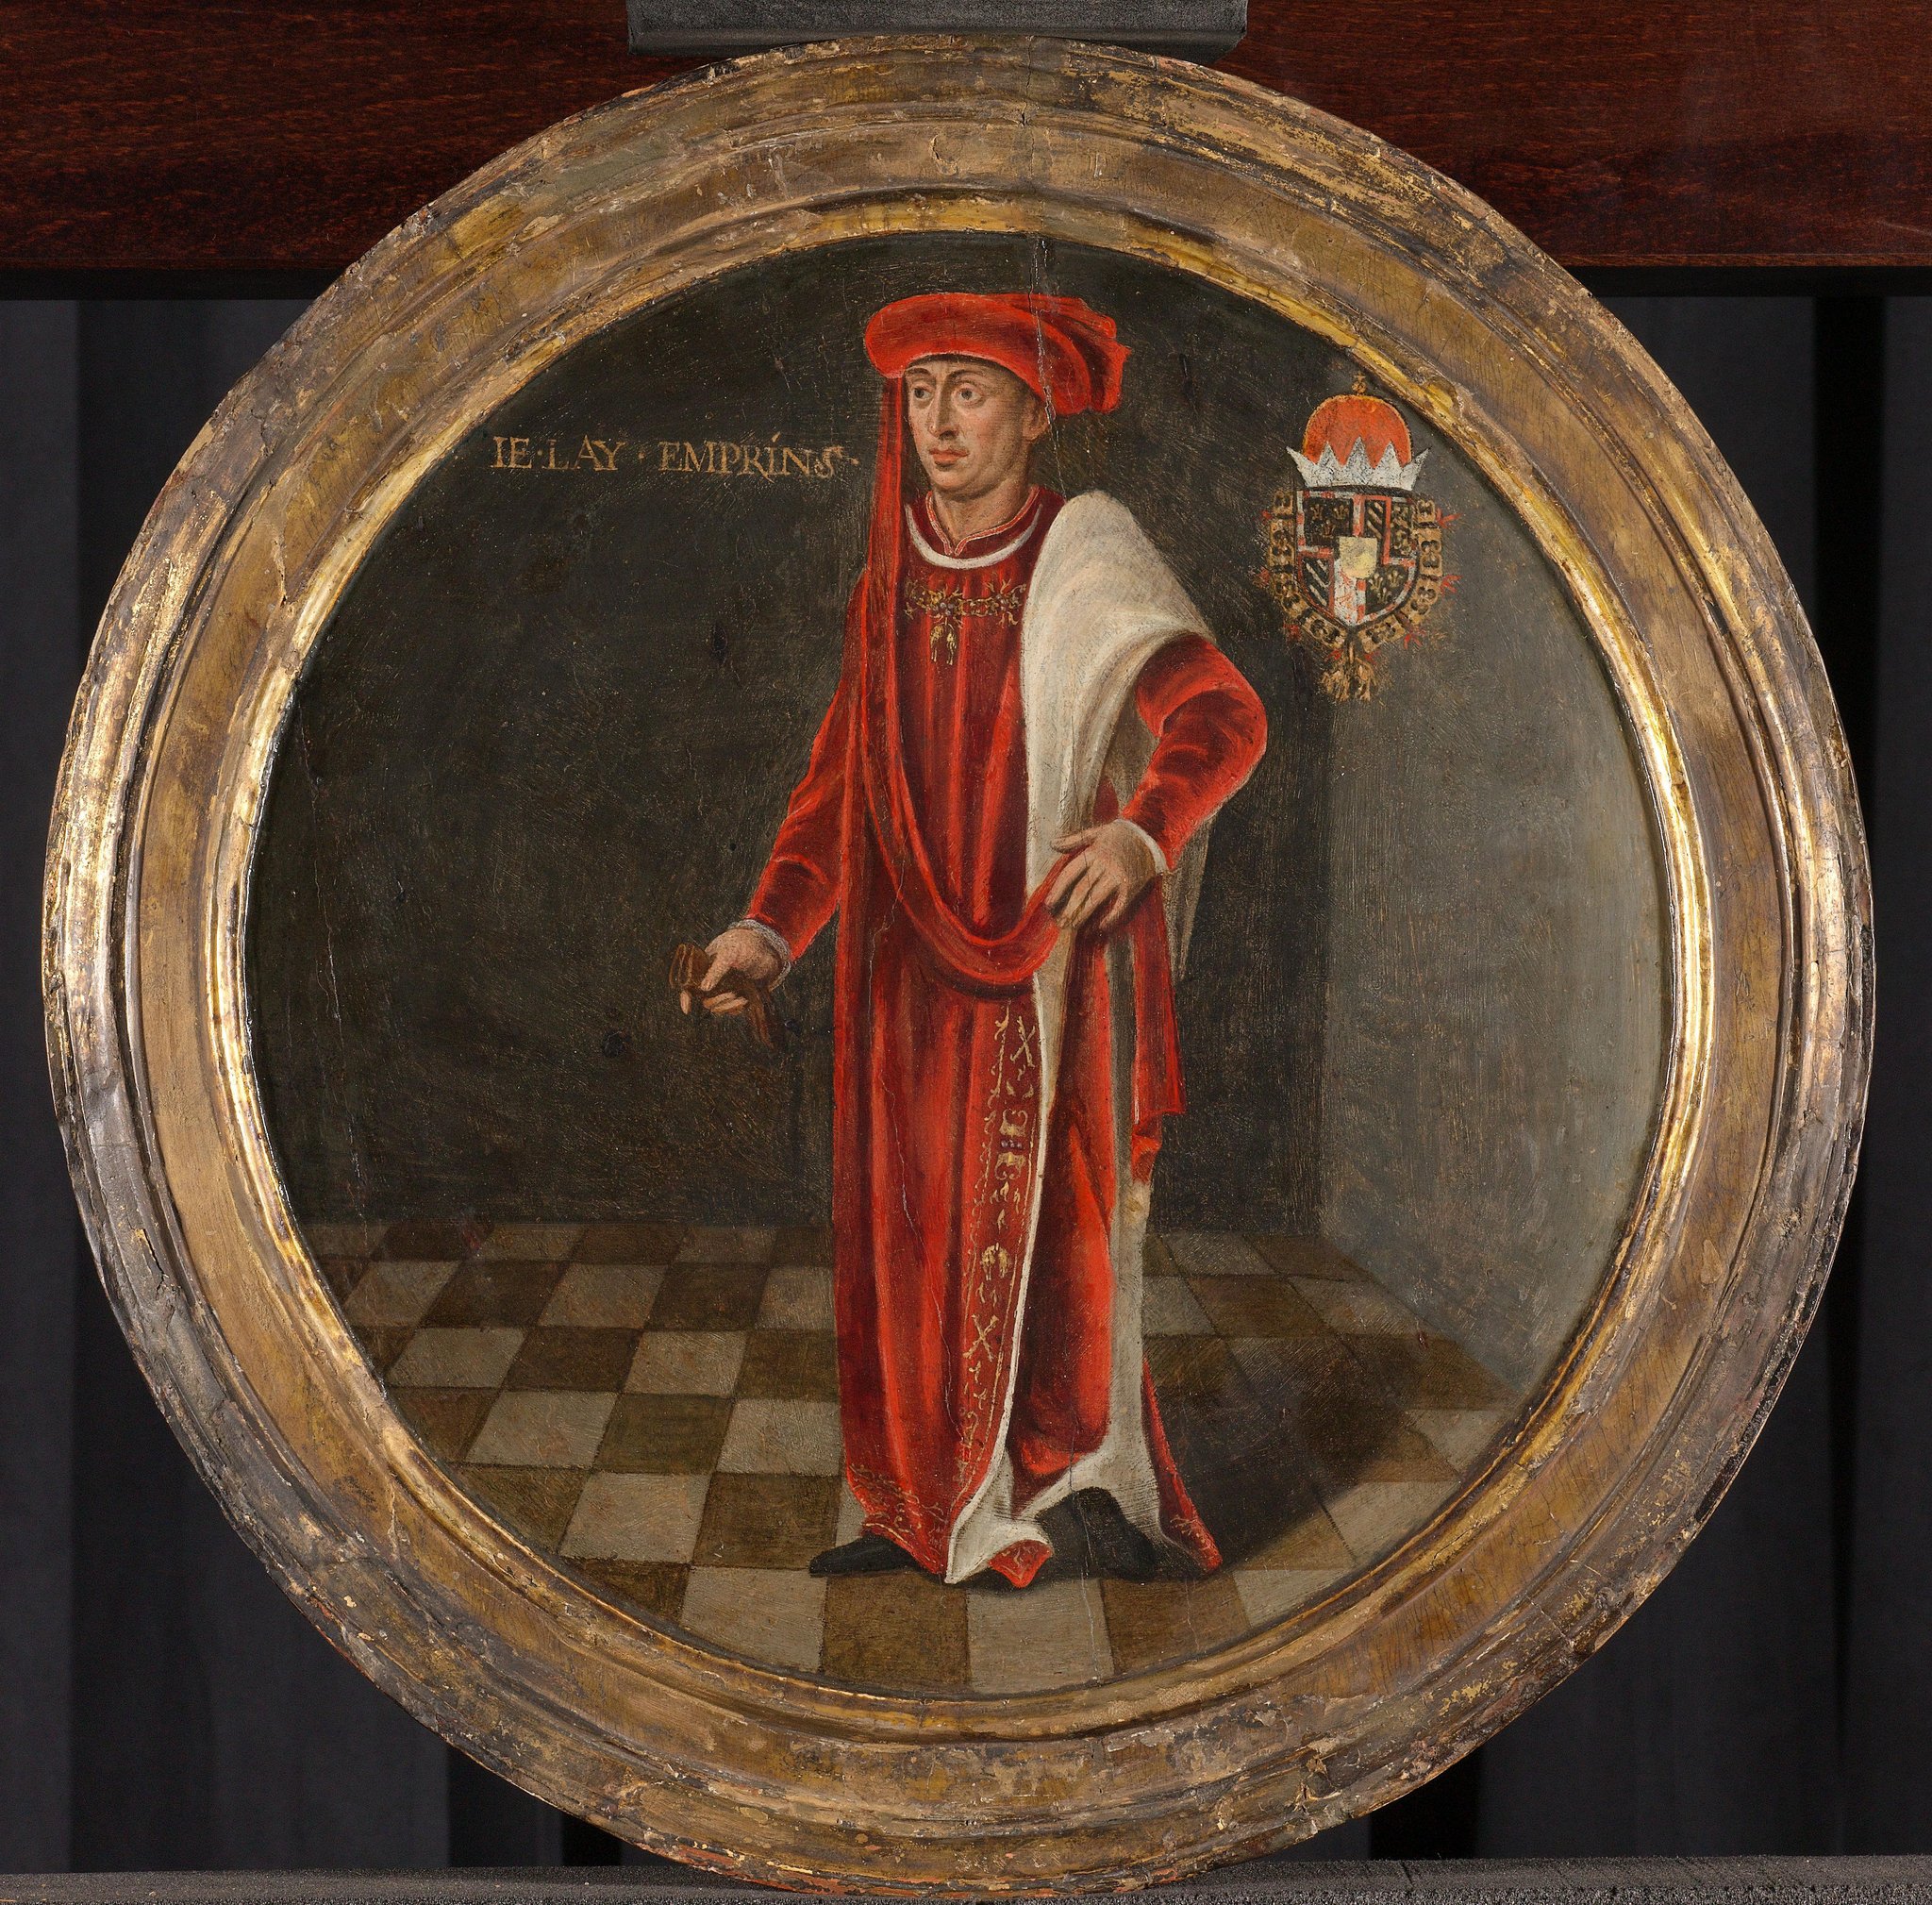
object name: painting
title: Portrait of Charles the Bold, Duke of Burgundy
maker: Anonymous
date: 1460-1480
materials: oil, panel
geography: southern netherlands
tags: earl, charles the bold (duke of burgundy), historical persons (+ full length portrait), armorial bearing, heraldry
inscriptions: inscription, upper left: ‘Le.Lay.Emprins’, coat of arms, upper right: quartered, 1 and 4, three gold fleurs-de-lis on a blue field; 2, divided vertically, i, three diagonal gold bands on a blue field, ii, a gold lion rampant on a black field; 3, divided vertically, i, three diagonal gold bands on a blue field, ii, a red lion rampant with gold claws on a silver field; an inescutcheon with a black lion rampant with red tongue and claws on a gold field. Crest: a silver crown and a red orb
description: Portret van Karel de Stoute, hertog van Bourgondië. Staande naar rechts, ten voeten uit op een tegelvloer. Om de hals de keten van het Gulden Vlies. Linksboven het familiewapen. Met geïntegreerde lijst. Pendant van SK-A-3835.